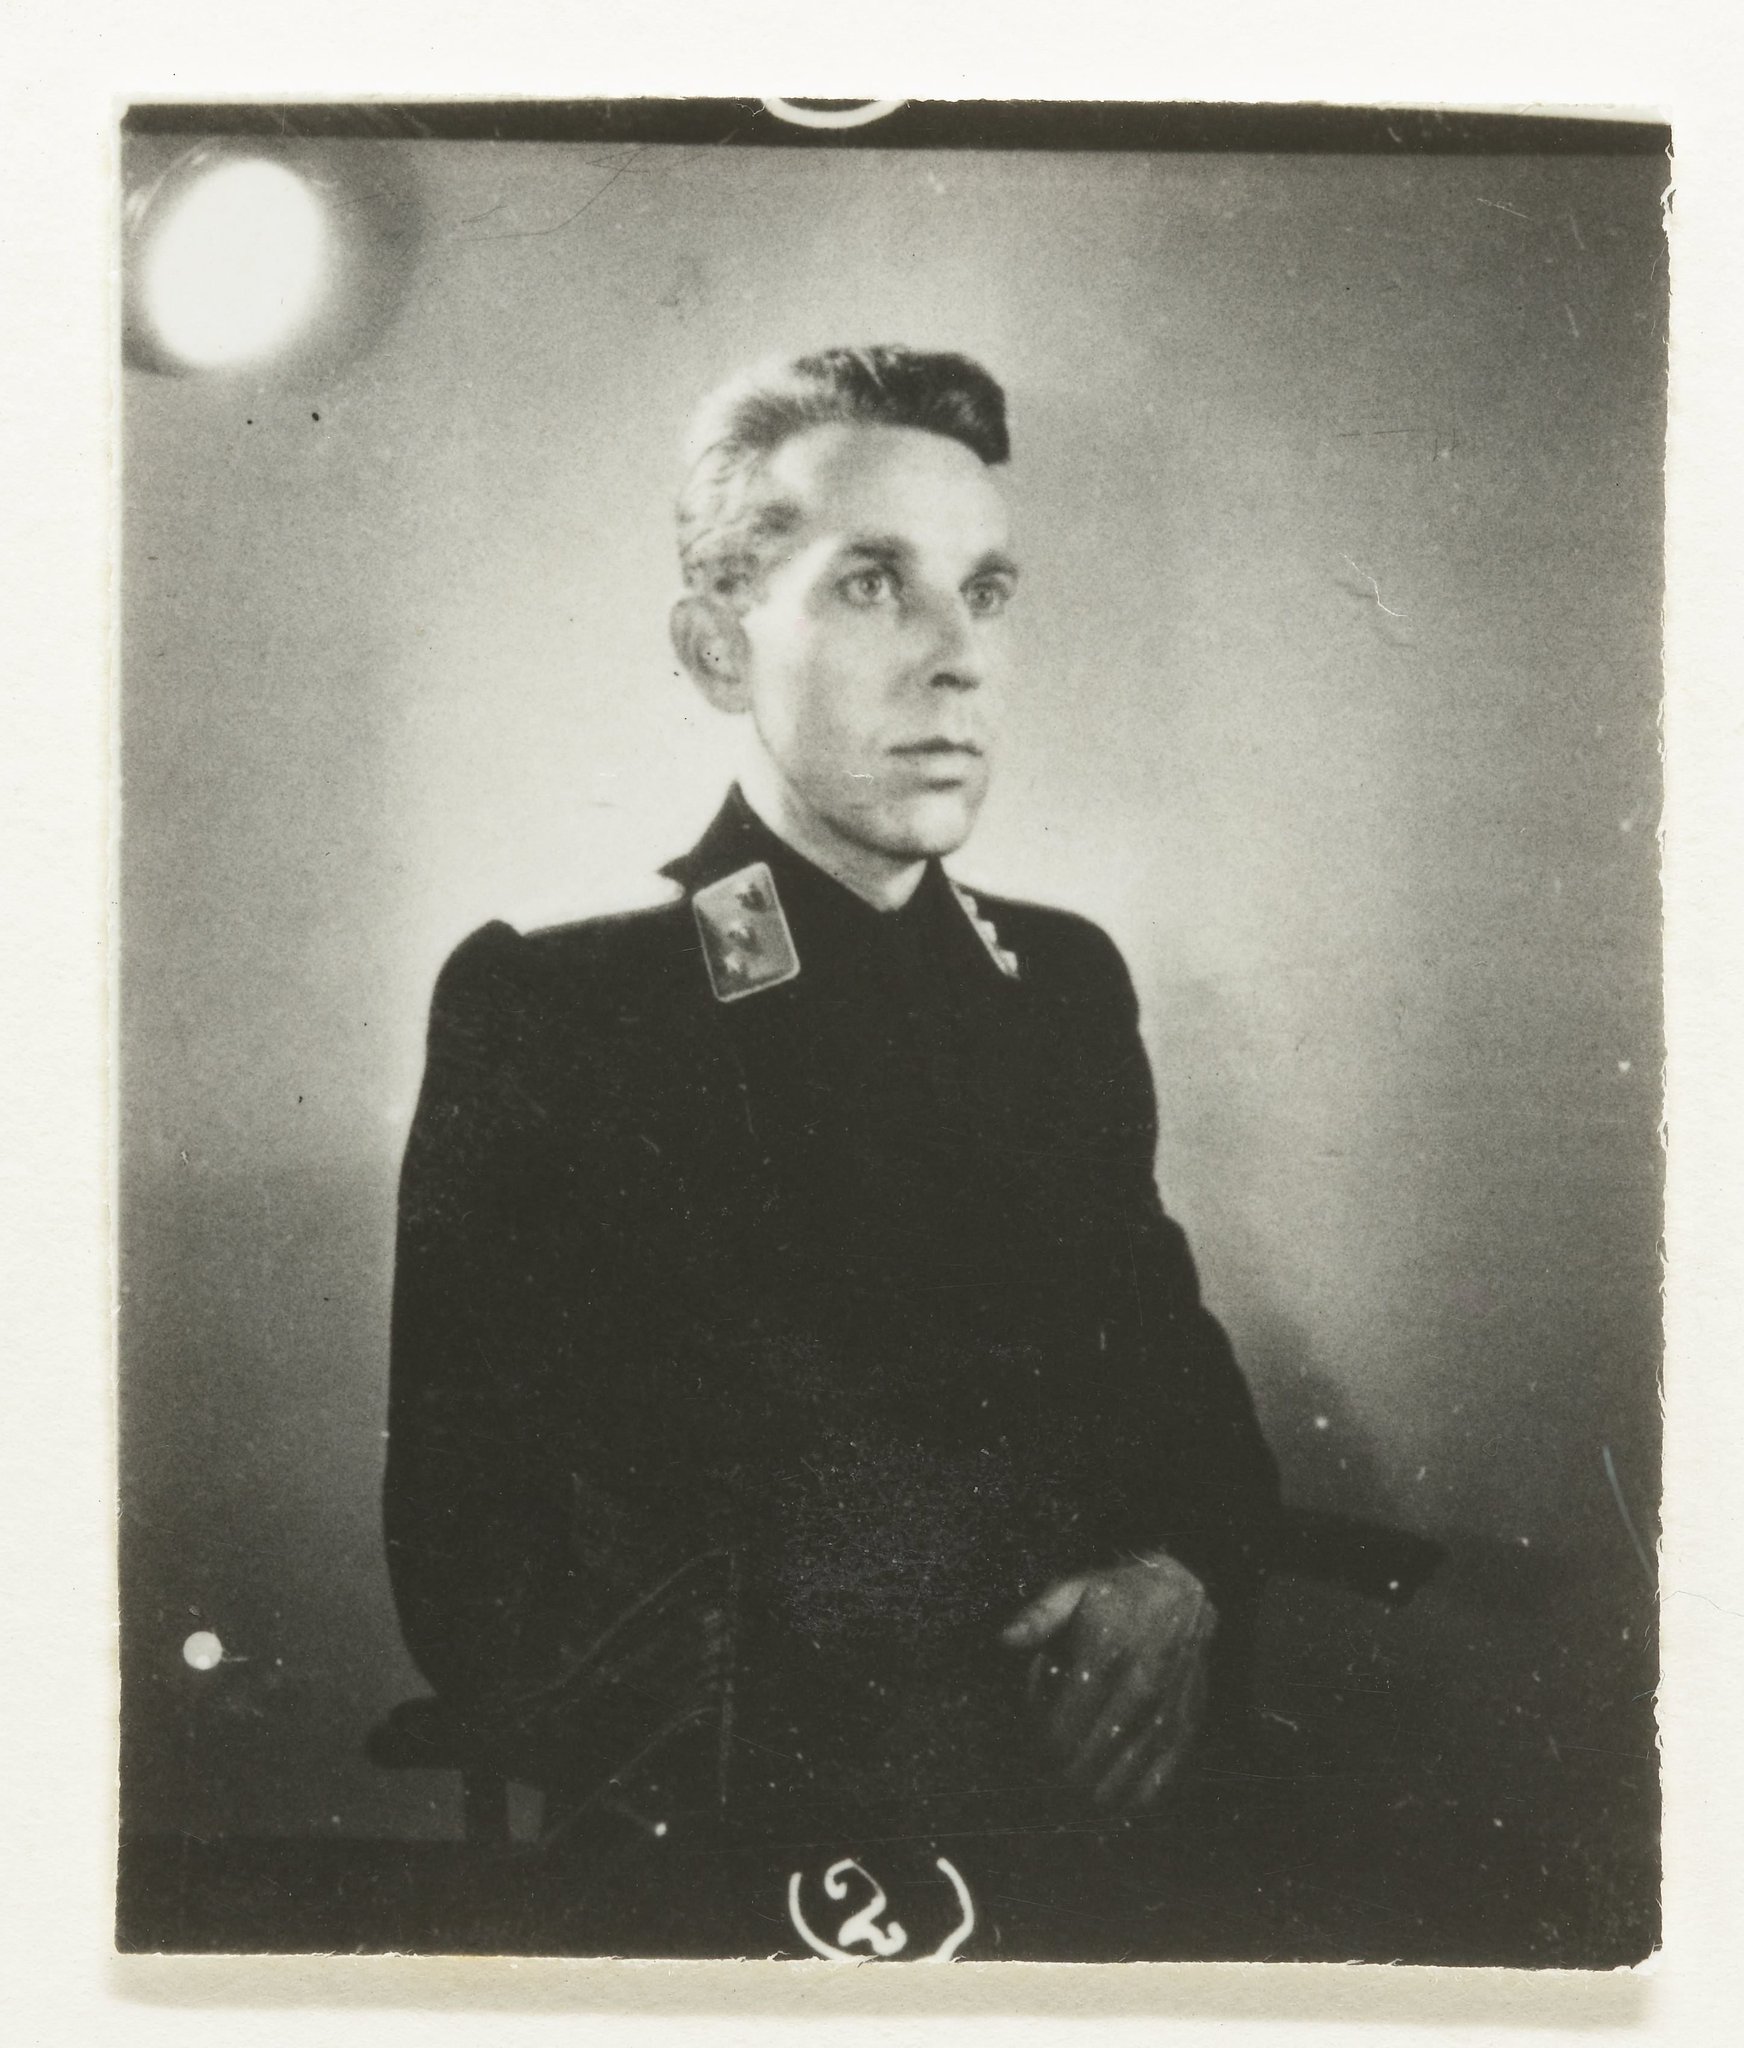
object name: contact print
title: Portret van een lid der NSB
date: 1940-1944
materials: photographic support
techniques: photography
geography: netherlands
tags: anonymous historical person portrayed, netherlands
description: Portret van een lid der NSB, zittend op een stoel. Achter hem een fotolamp. Blootshoofd. Het zou kunnen gaan om een kringleider, zie distinctief met drie sterren op zijn kraag. Een kring was onderdeel van een district, meestal een plaats of stad.